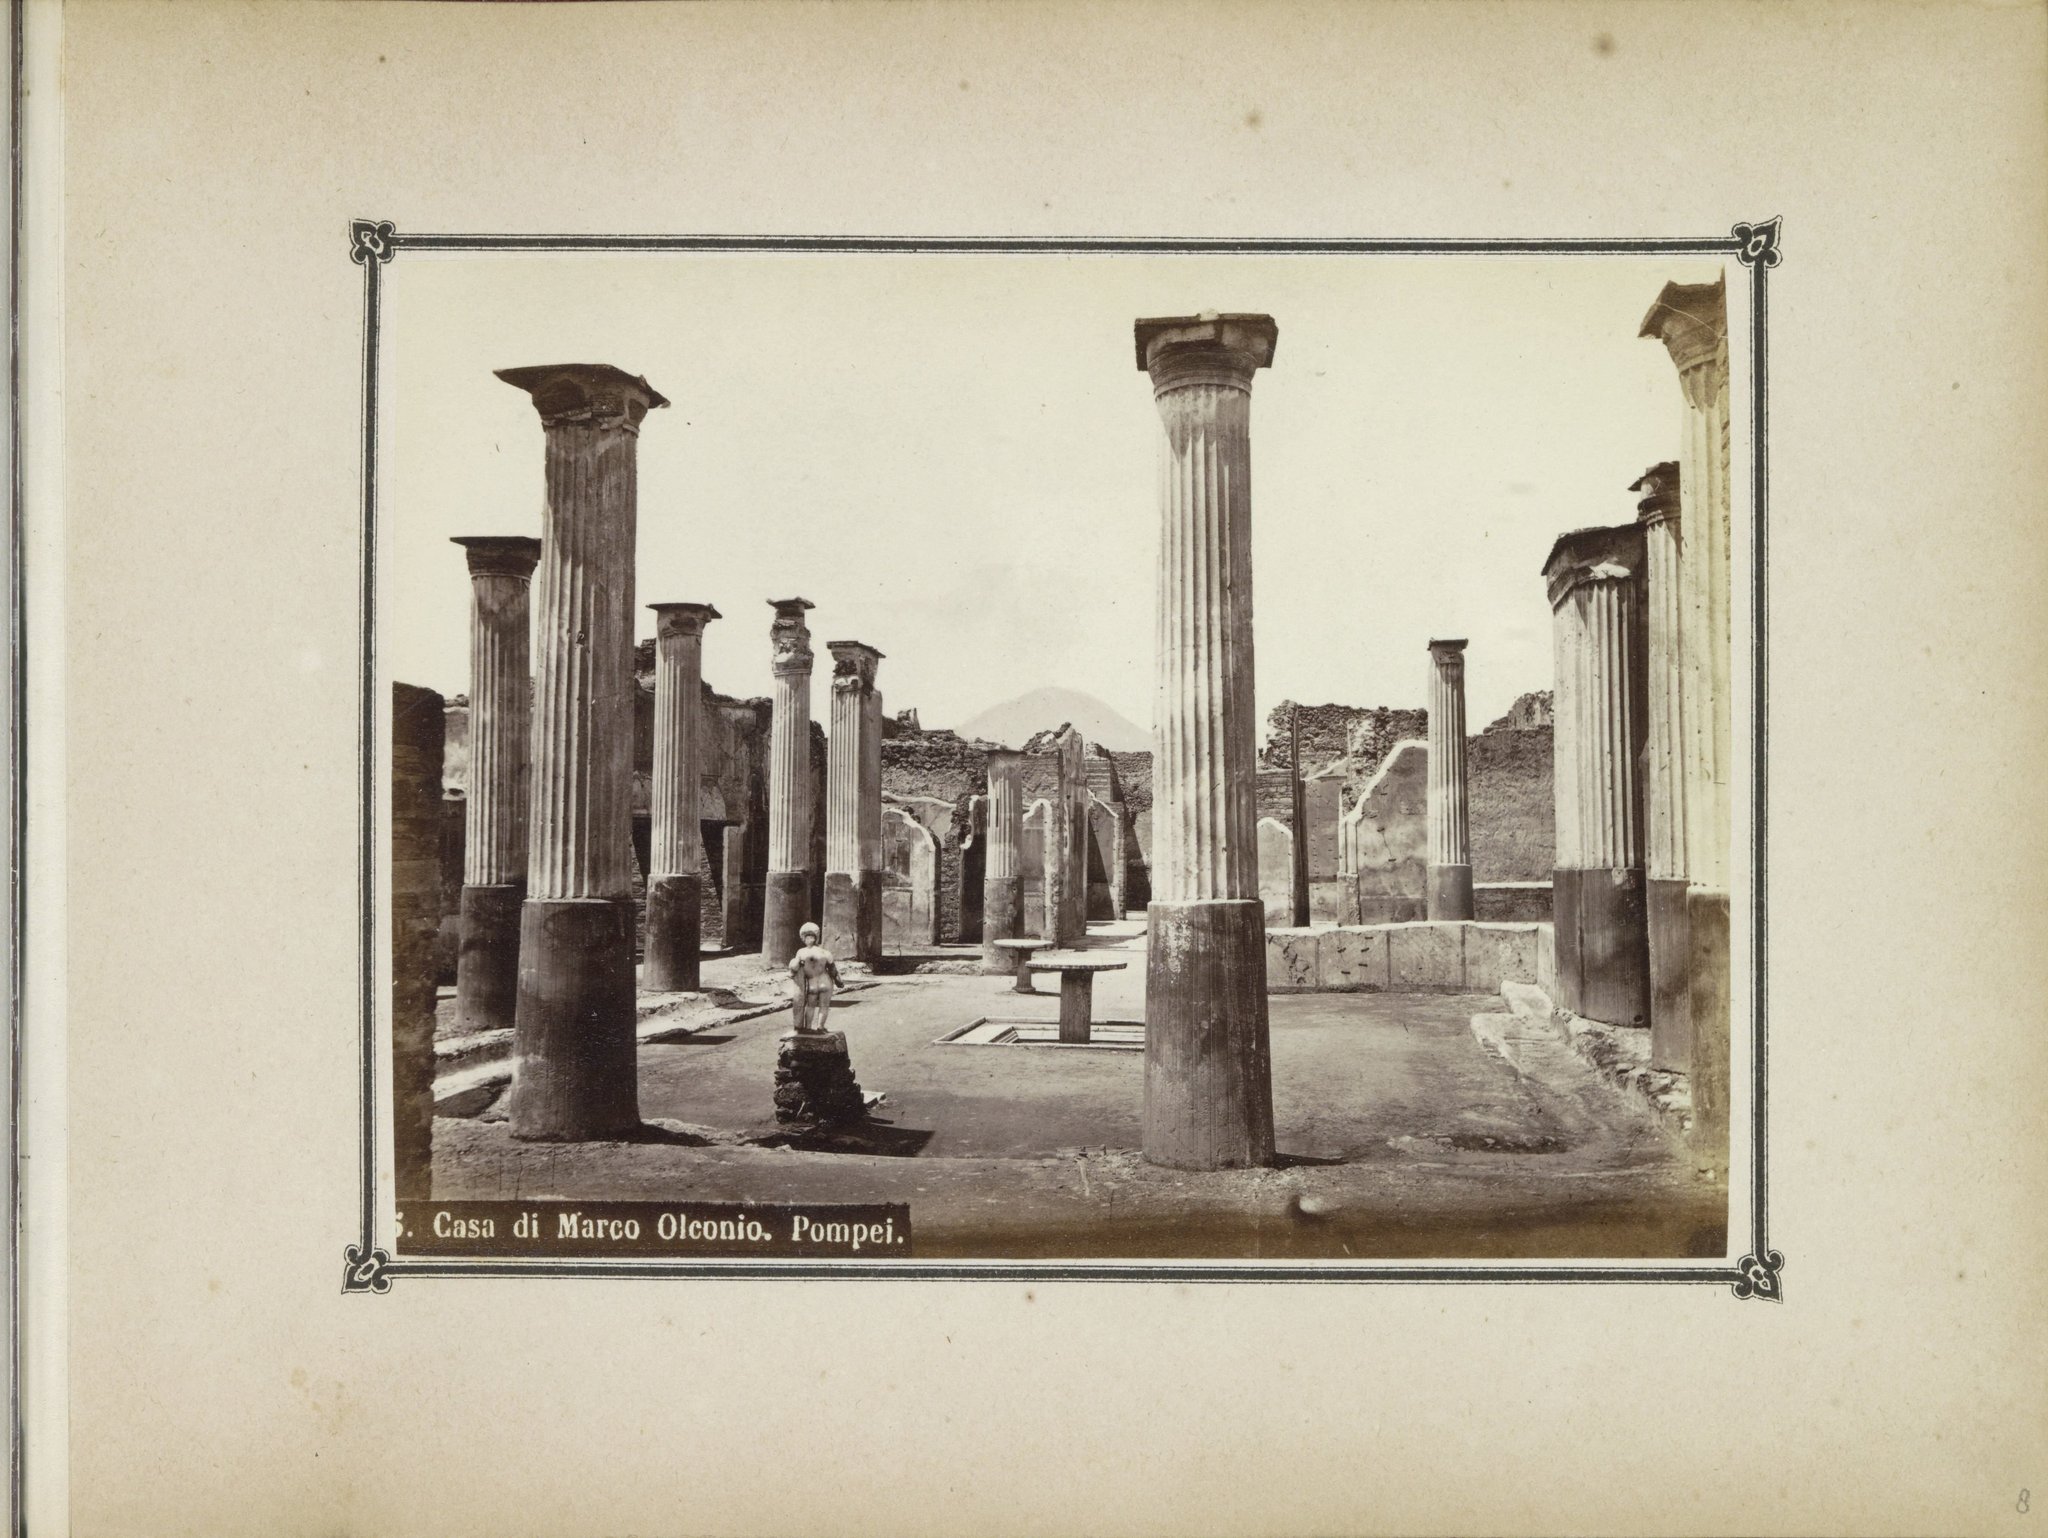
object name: photograph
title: Pompei. Tempio di Mercurio.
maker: roberto rive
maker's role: fotograaf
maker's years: 1825-1868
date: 1860-1900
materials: paper, photographic support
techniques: albumen print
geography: pompeii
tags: villa, excavation ~ archaeology, pompeii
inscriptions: number: ‘[...]’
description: Onderdeel van Fotoalbum met opnames van opgravingen in Pompeï door Roberto Rive.